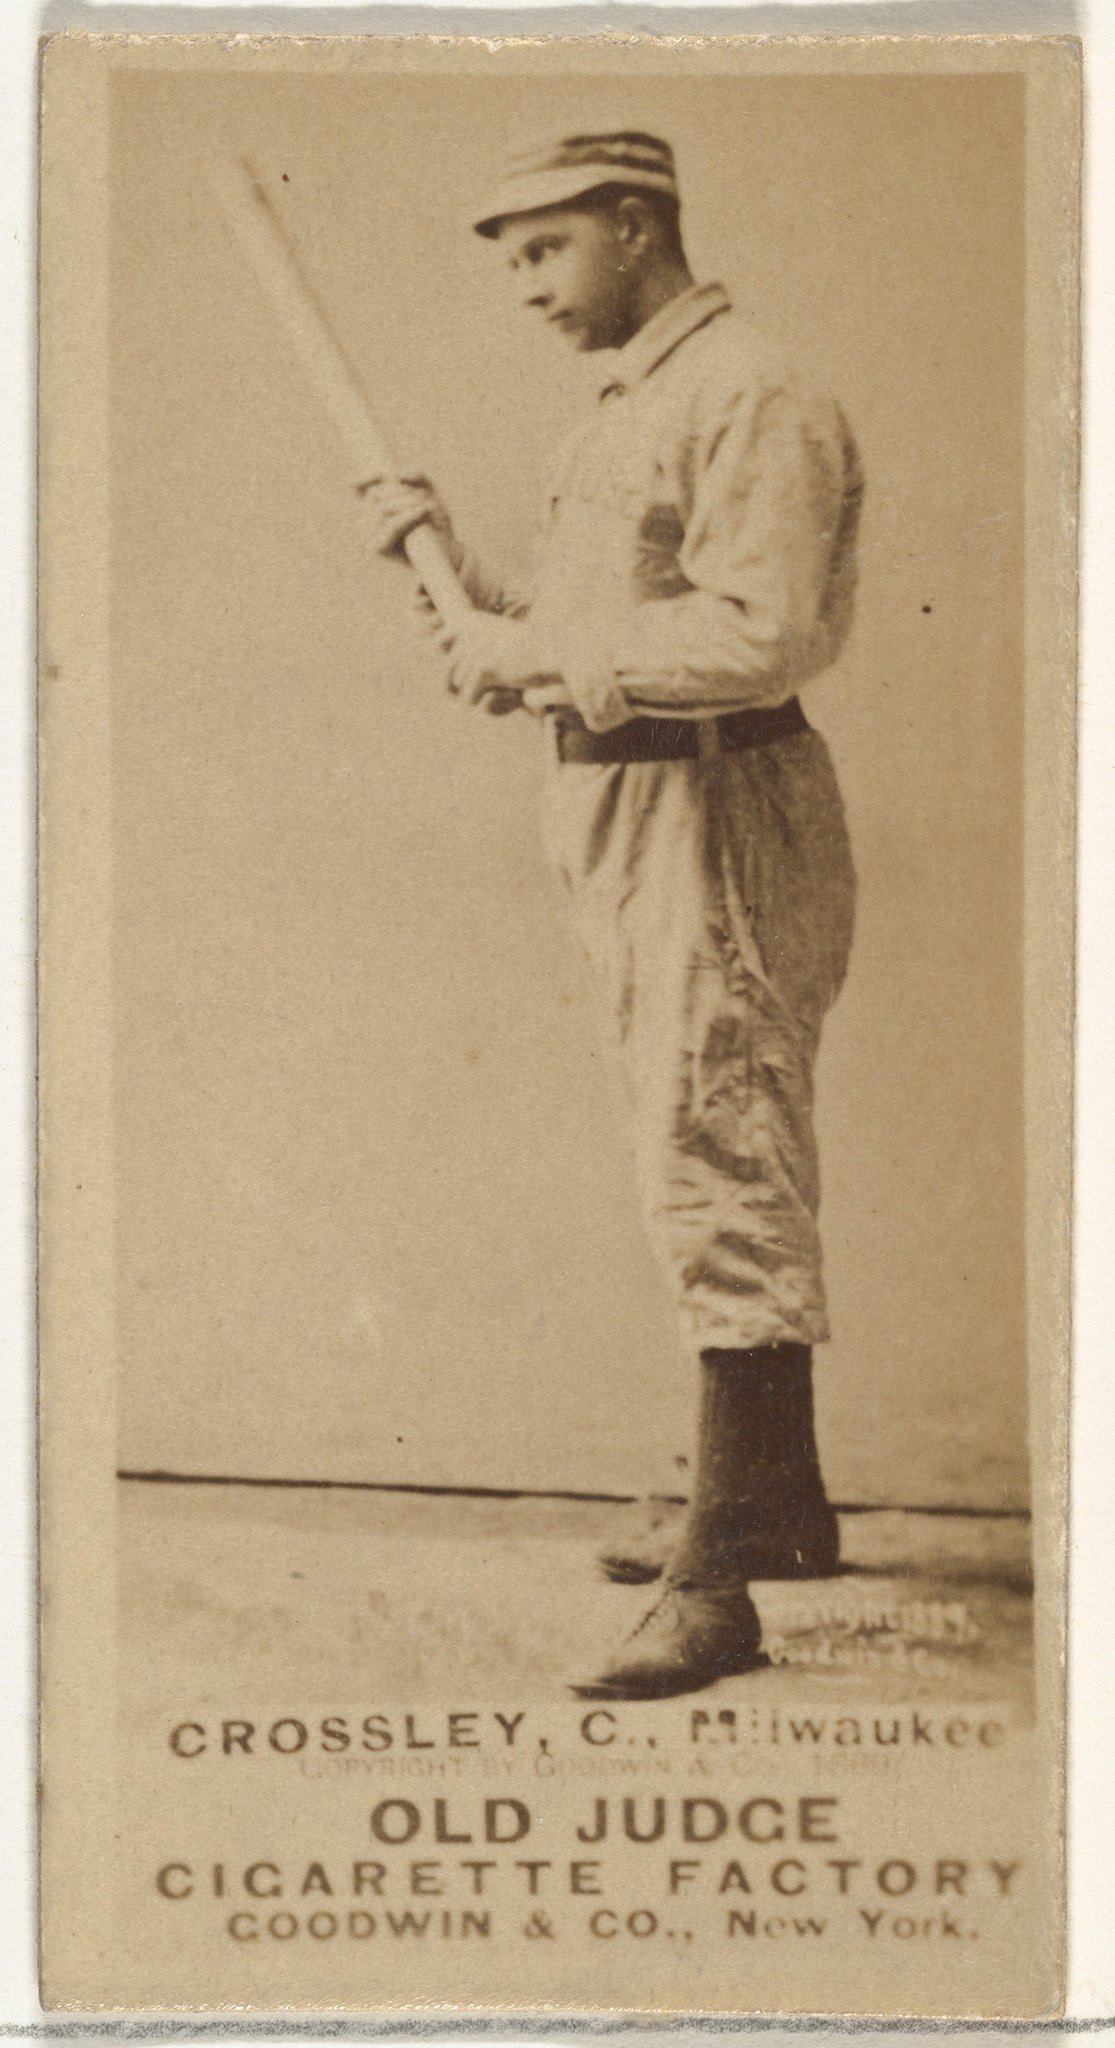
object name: baseball card, photograph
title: William C. Crossley, Catcher, Milwaukee, from the Old Judge series (N172) for Old Judge Cigarettes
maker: goodwin & company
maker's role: publisher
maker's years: 1850-1950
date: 1889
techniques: albumen silver print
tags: men,portraits,baseball,athletes